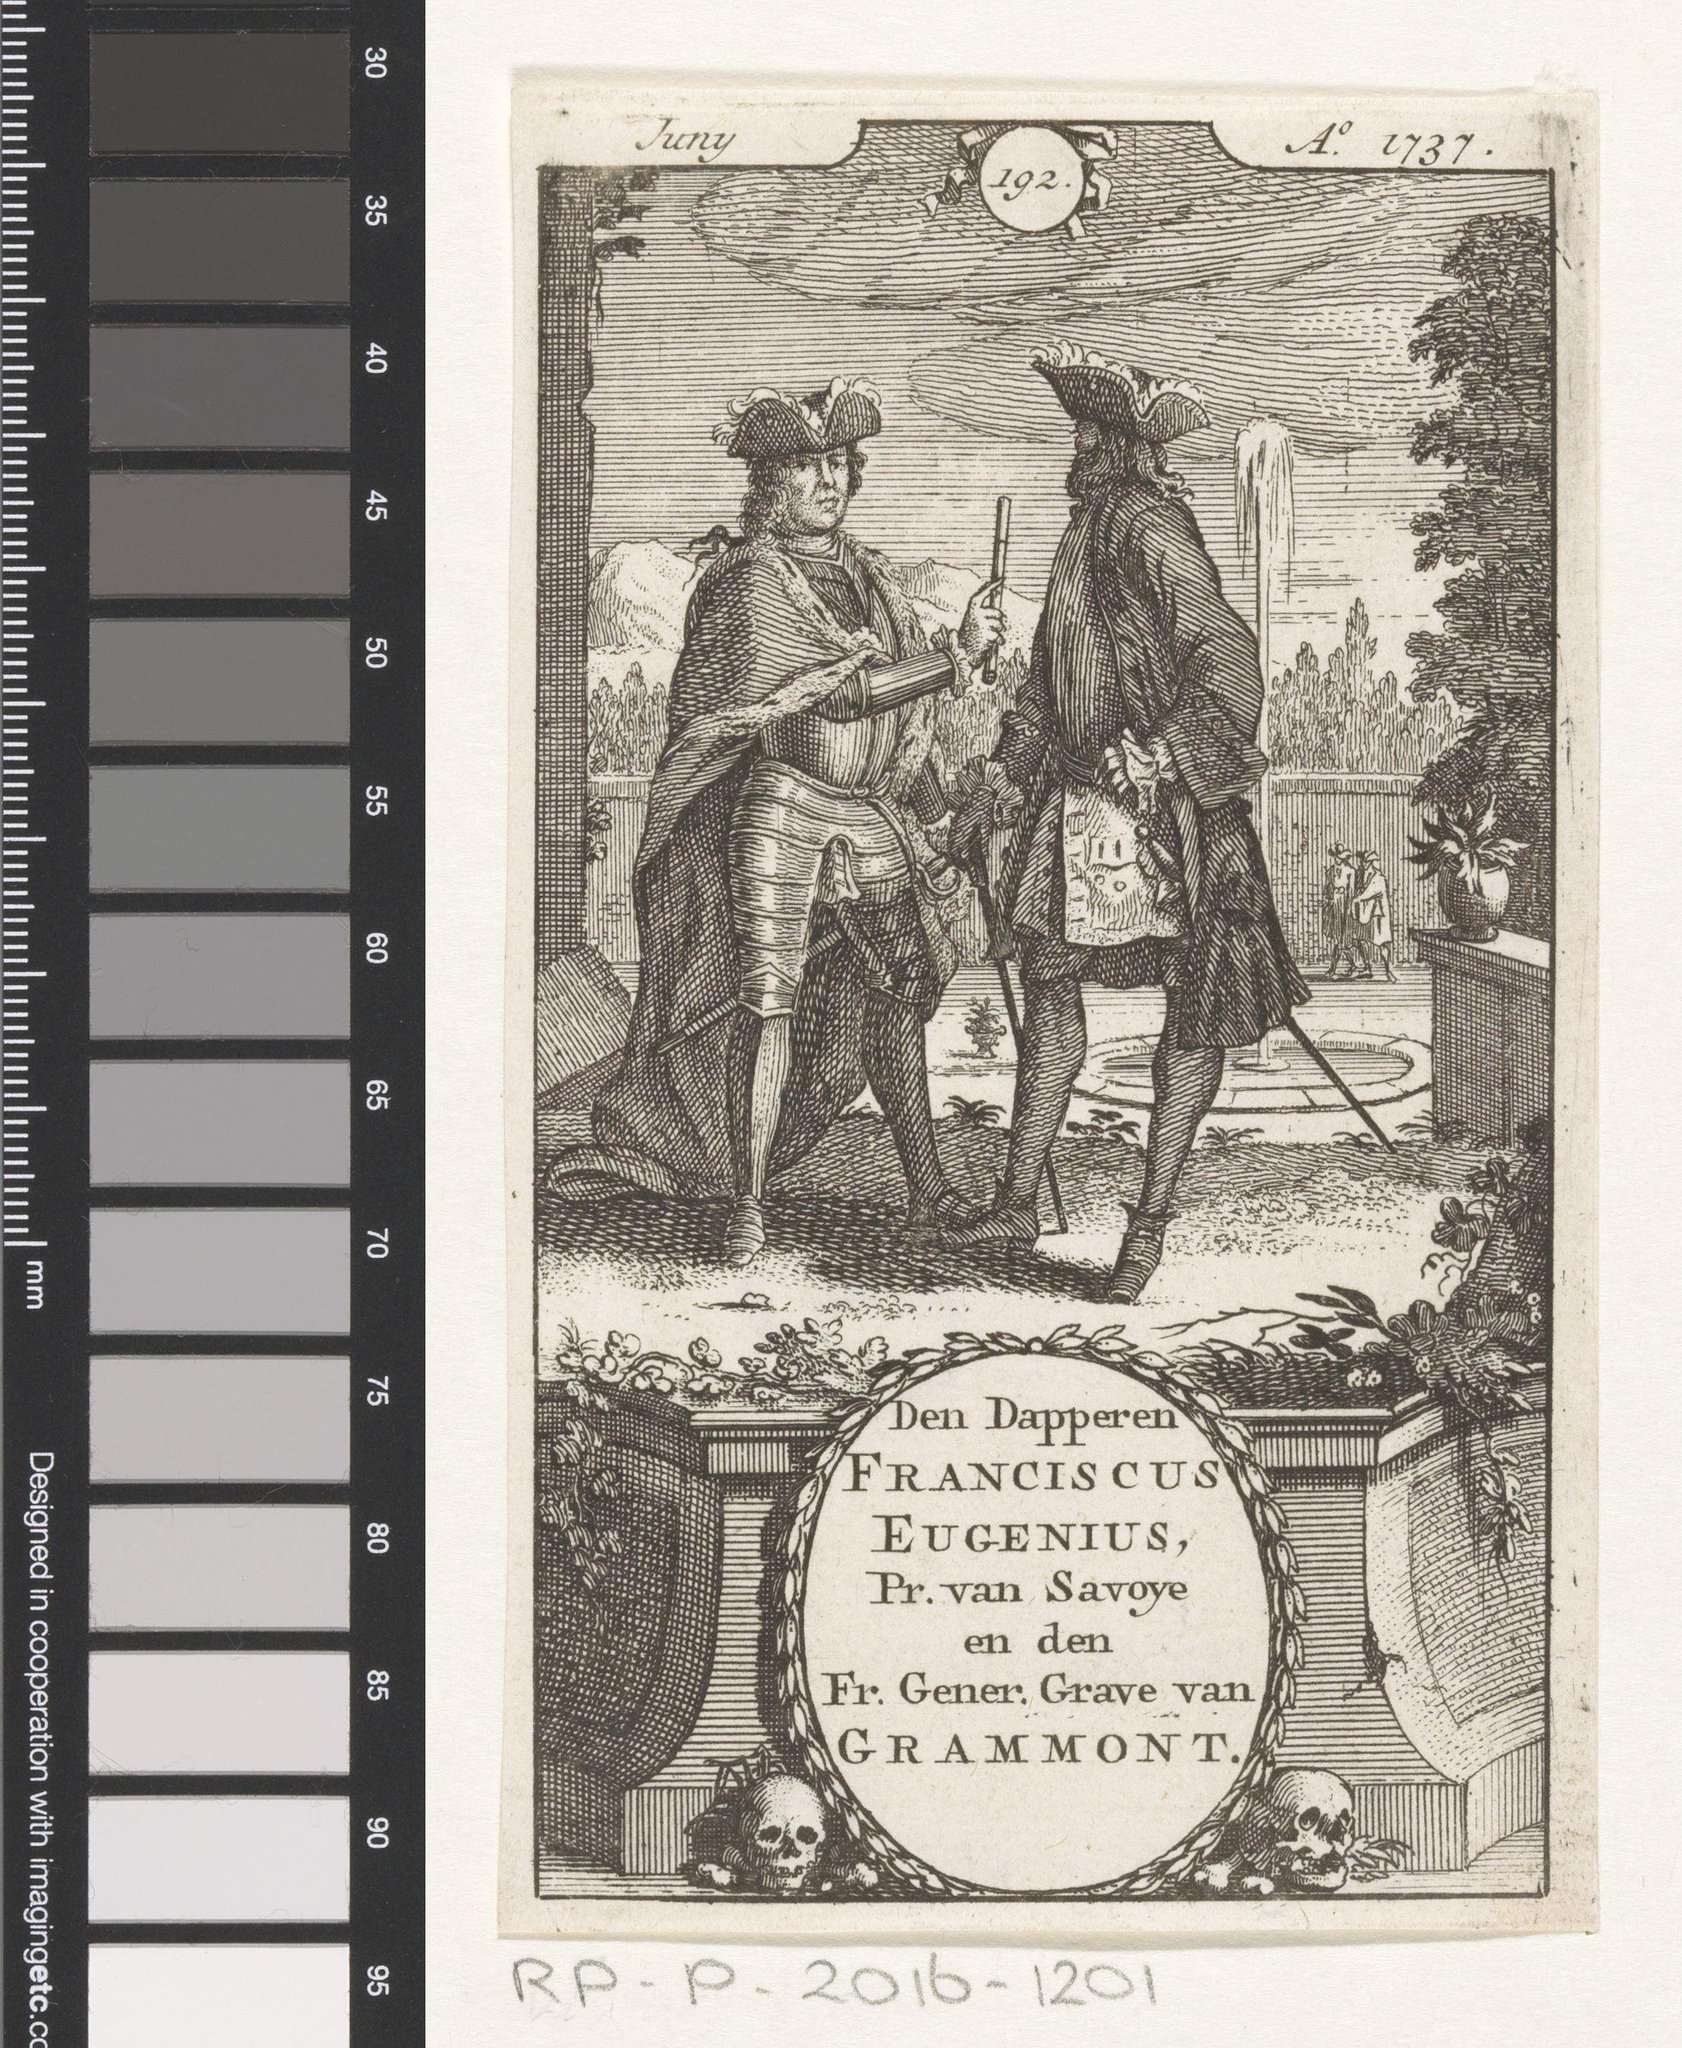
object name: book illustration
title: Gesprek tussen Eugenius van Savoye en Philibert de Gramont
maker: Anonymous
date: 1706-1737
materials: paper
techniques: etching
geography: amsterdam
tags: vienna, eugenius van savoye, garden, conversation, dialogue; conversation piece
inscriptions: collector's mark: Lugt 2228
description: Prent uit het tijdschrift: S.n. Maandelyksche berichten uit de andere waerelt; of de spreekende dooden. Amsterdam: Ratelband, erven Johannes, juni 1737. Prent afkomstig uit een plakalbum met titelprenten, ornamenten etc. op blauw papier in 1983 uit elkaar gehaald. Volgens een notitie op verso zat de prent op p. 112 van dit album.